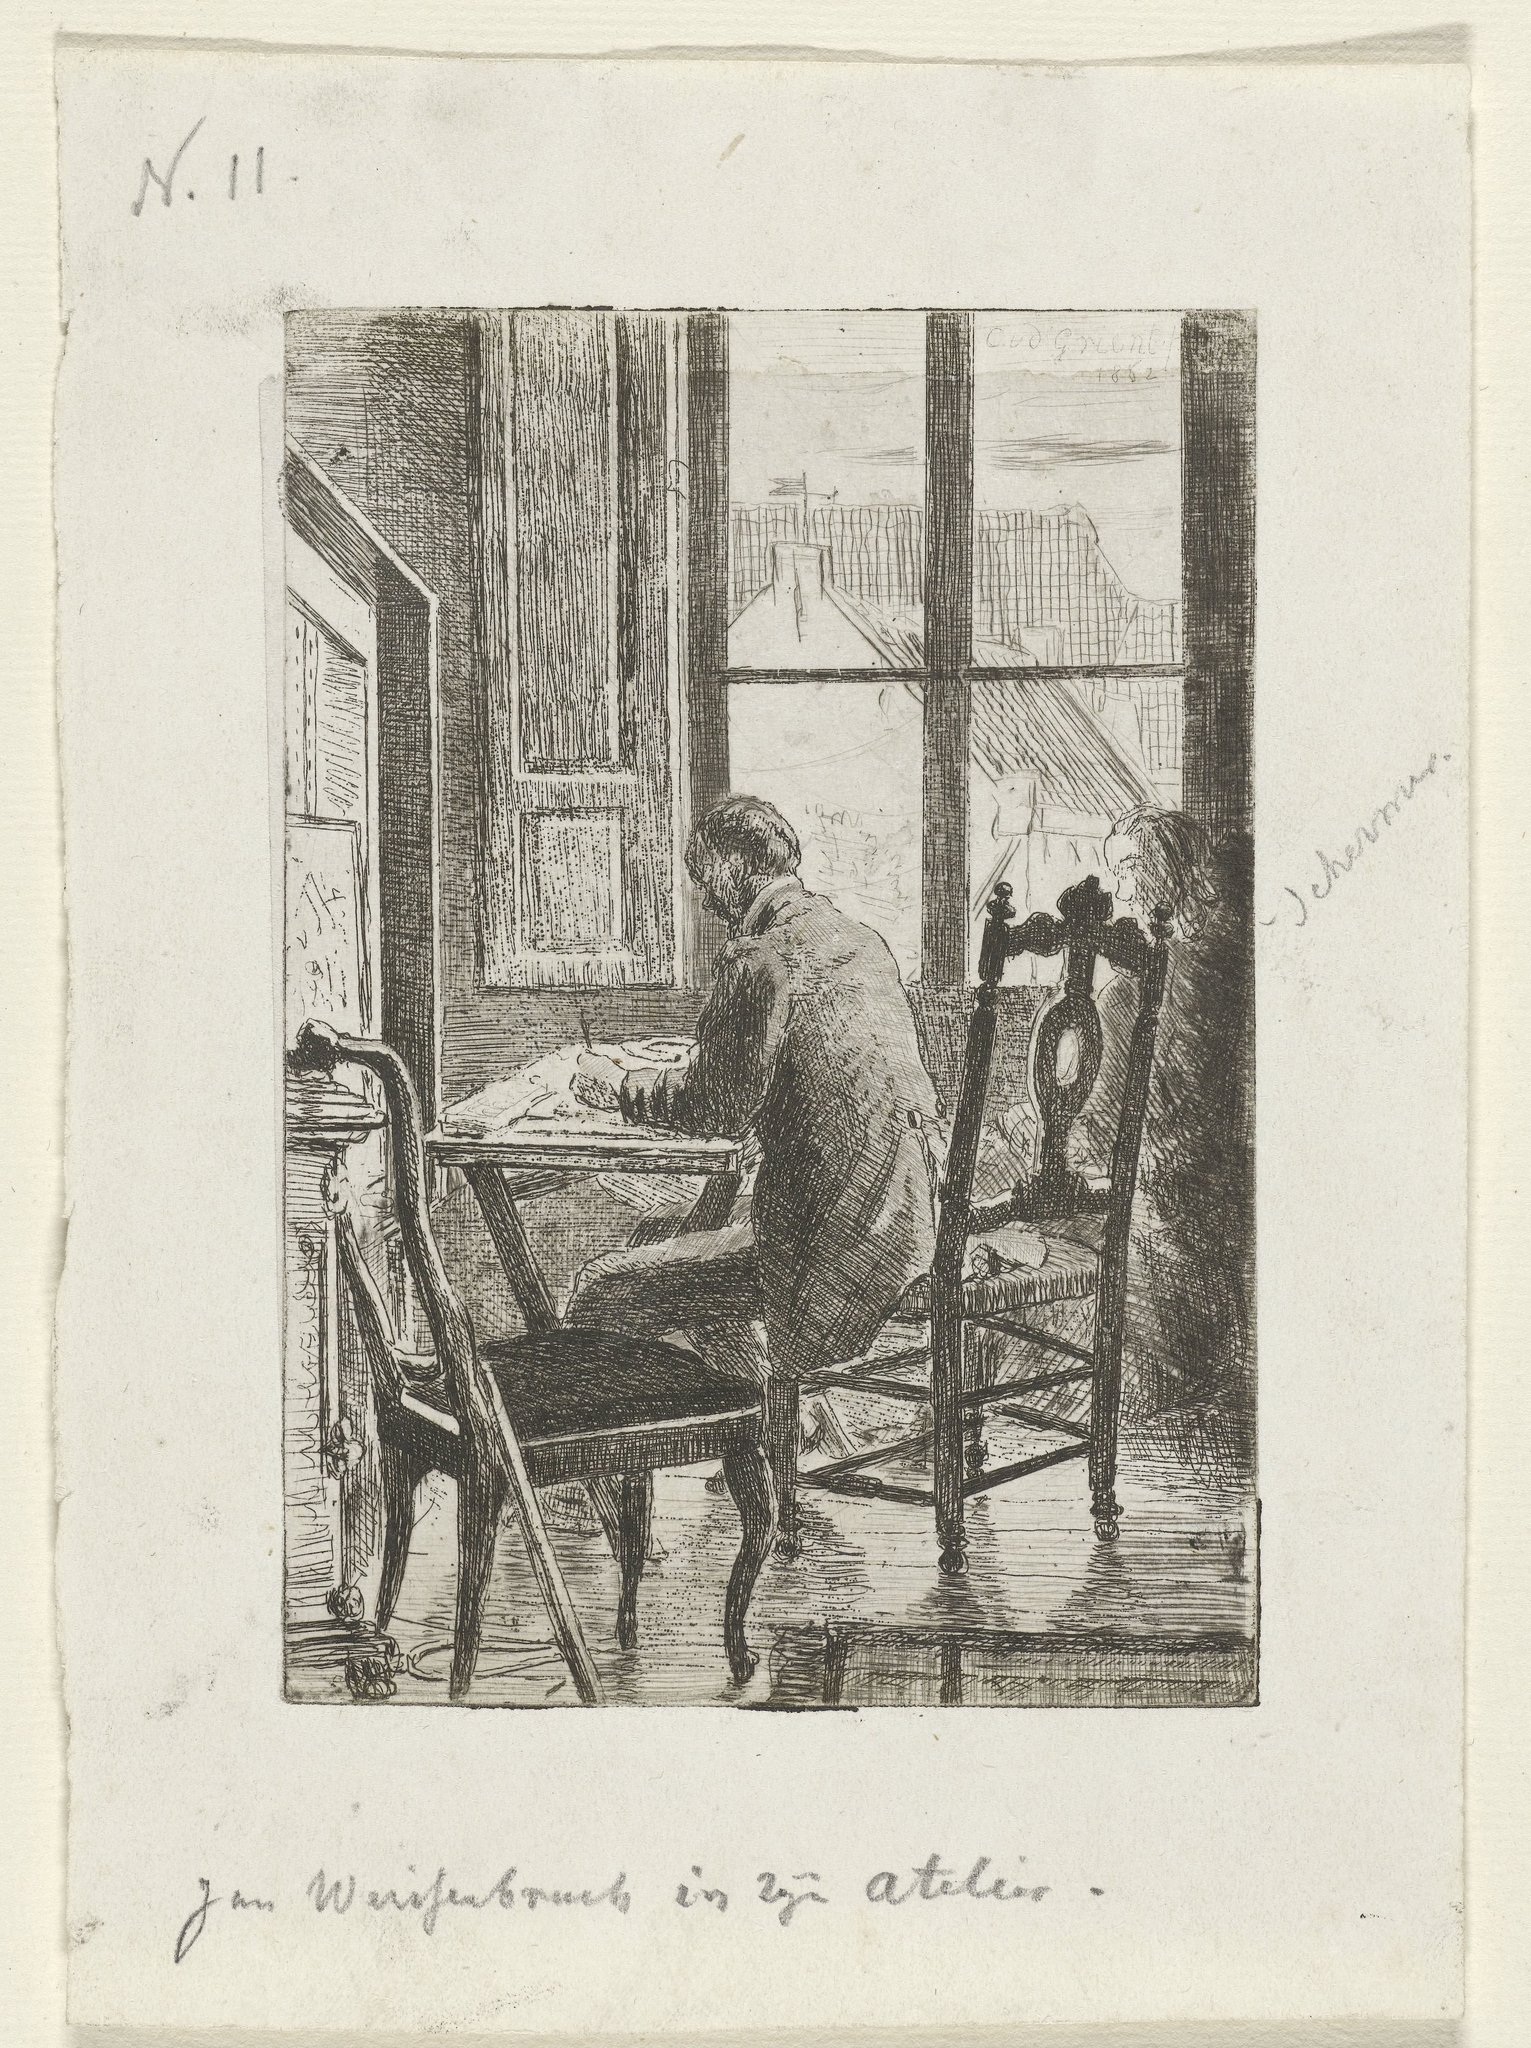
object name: print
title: Portret van Jan Weissenbruch in zijn atelier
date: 1862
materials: paper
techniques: drypoint, etching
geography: netherlands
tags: painter, print maker, jan weissenbruch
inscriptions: collector's mark: Lugt 2228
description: Portret van Jan Weissenbruch aan een tafel in zijn atelier. Aan de rechterzijde een figuur.